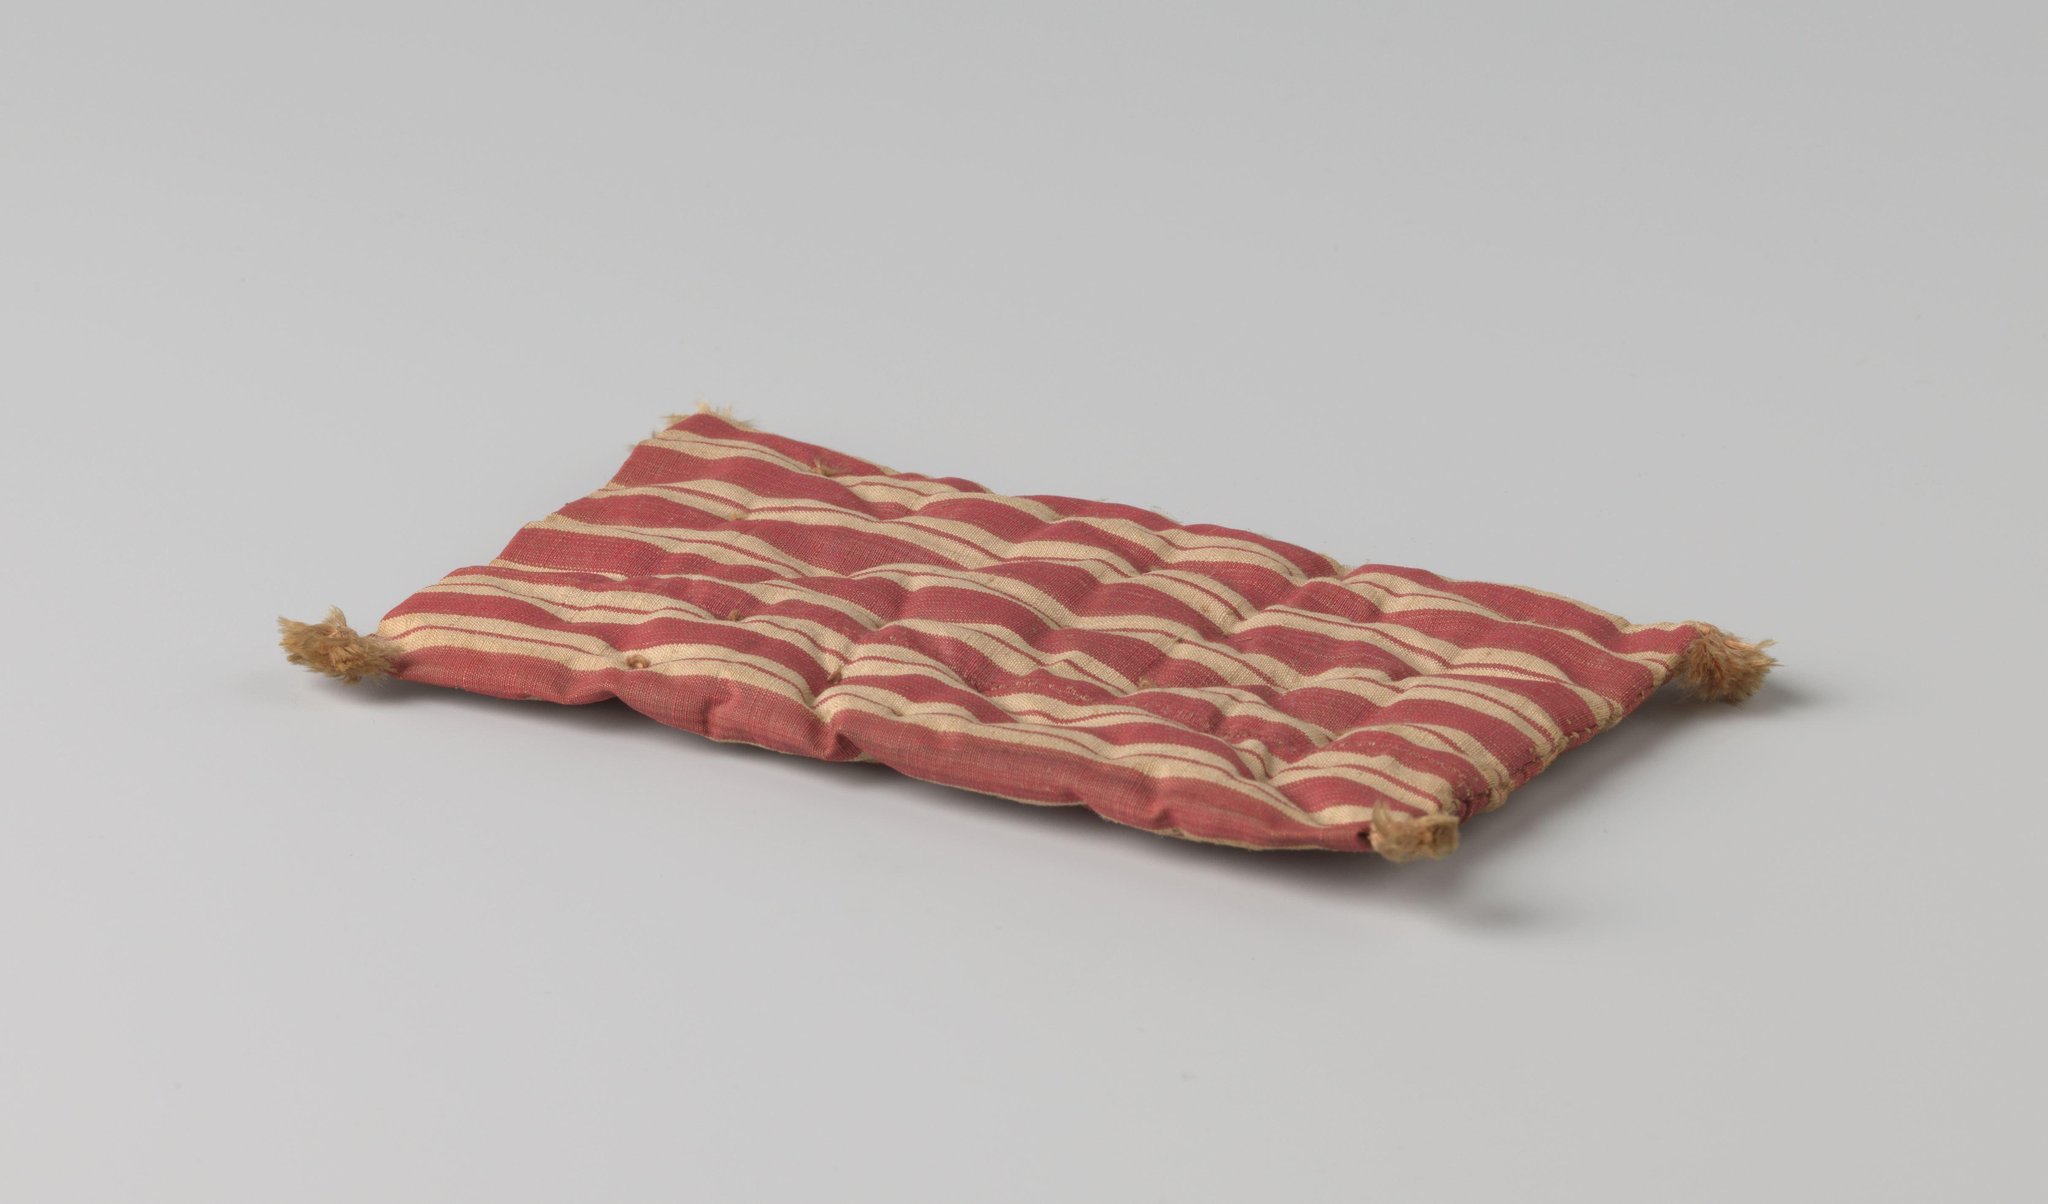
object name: miniature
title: Matras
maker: Anonymous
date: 1740-1760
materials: down, silk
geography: amsterdam